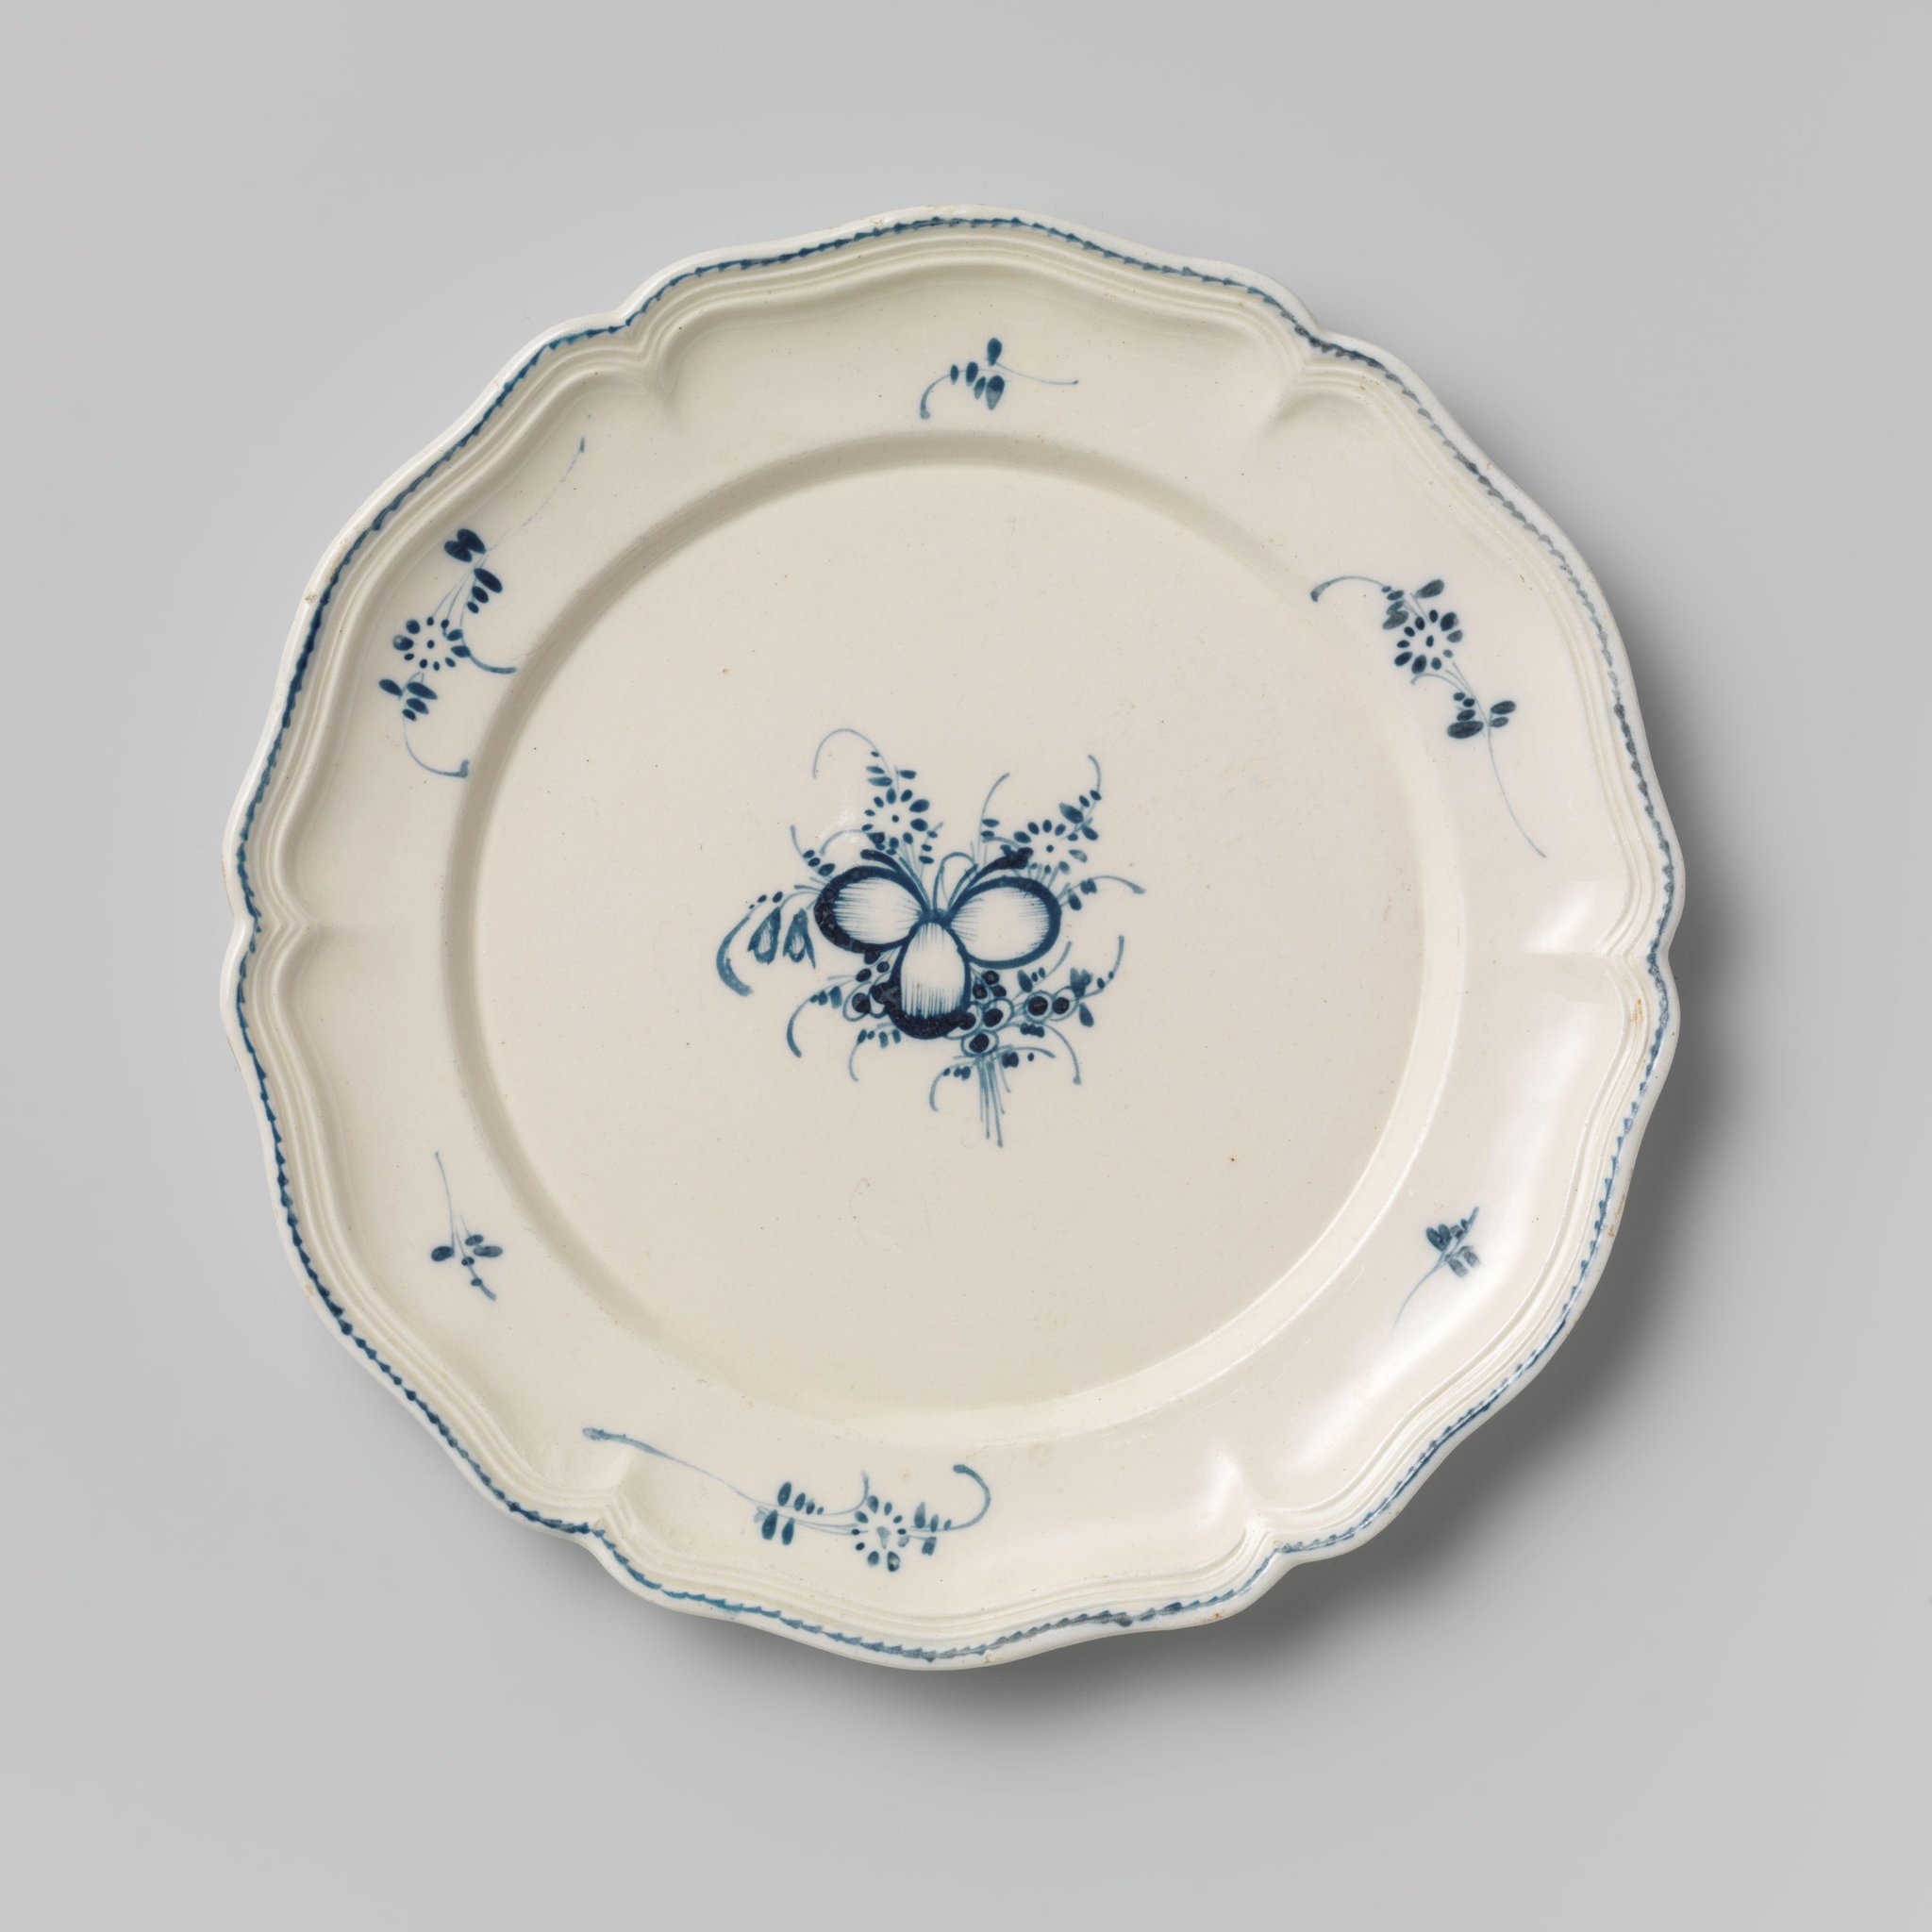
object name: plate dish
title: Bord van Engels hardgebakken aardewerk, Boch.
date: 1775-1810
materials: earthenware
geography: luxembourg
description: Rond bord van hardgebakken aardewerk. Het bord heeft een geschulpte rand en is beschilderd met klaverbladboeketten en takken. Langs de rand loopt een blauwe streepjesbies. Het bord is gemerkt.